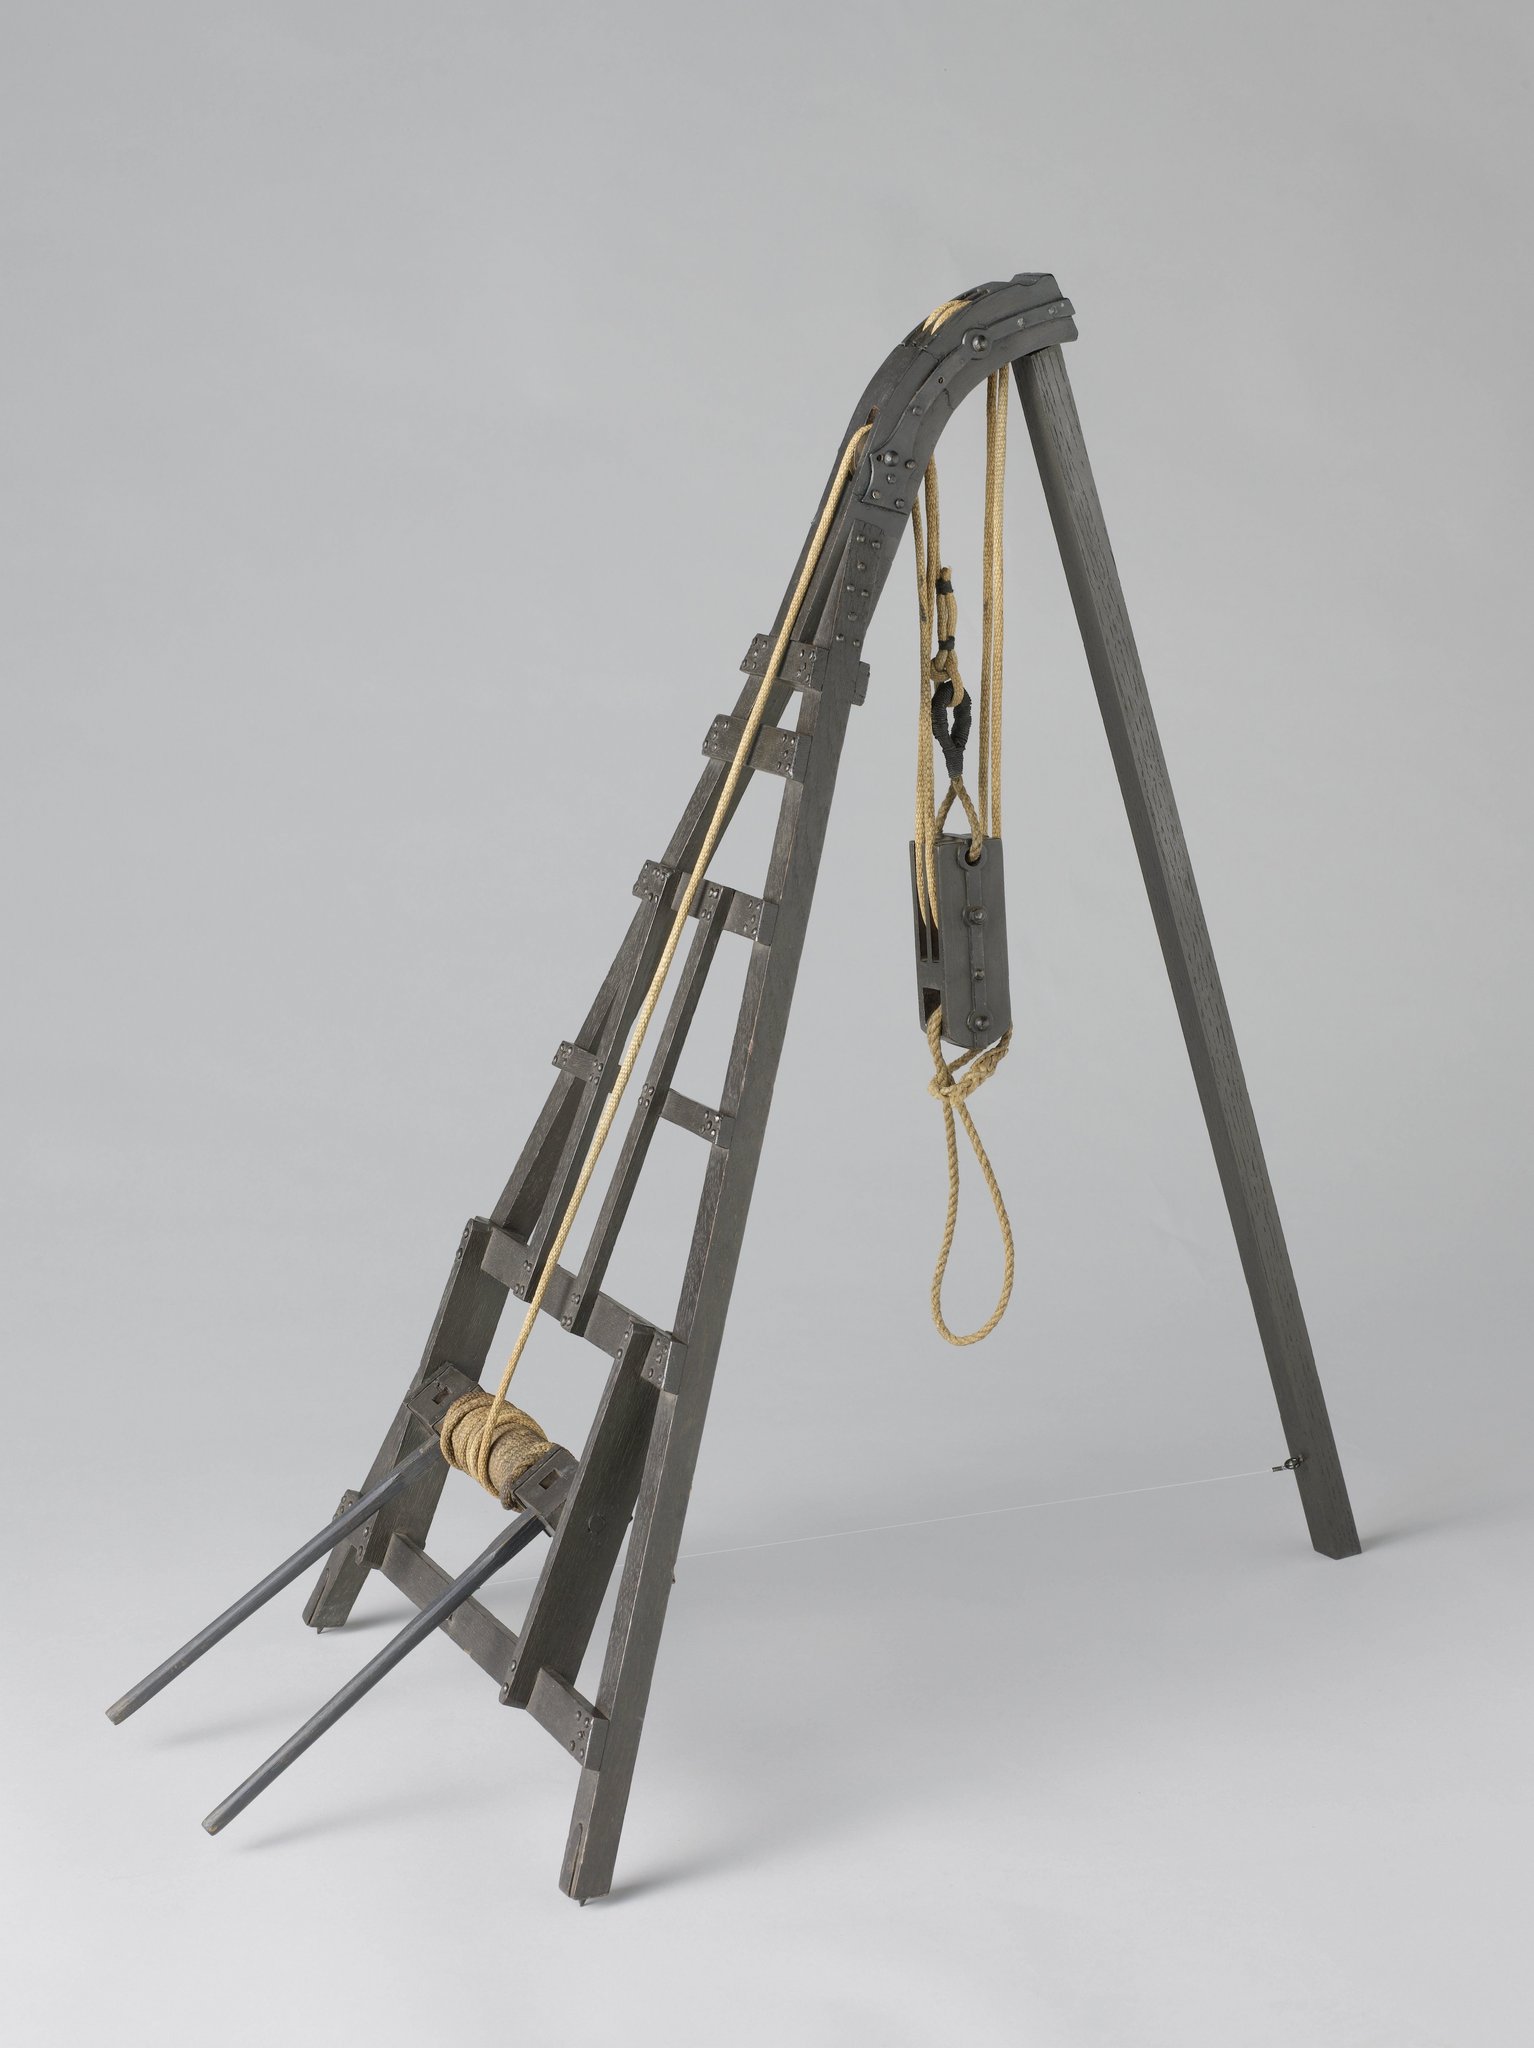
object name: gunmodel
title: Model driebenig vestingbok met enkele spil; met kanon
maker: Anonymous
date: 1750-1800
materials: iron, fiber, wood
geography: netherlands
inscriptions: number: ‘KA 15547’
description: Waarschijnlijk een veldbok in plaats van een vestingbok. De veldbok onderscheidt zich van de vestingbok in mobiliteit, eenvoudiger verplaatsbaar.